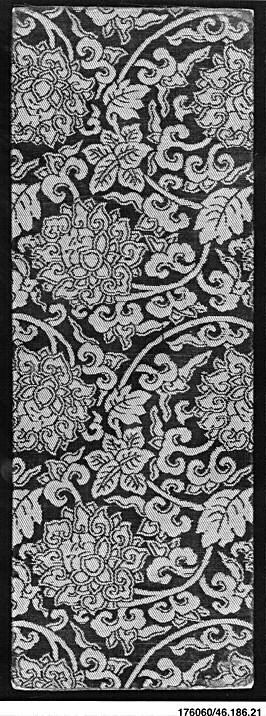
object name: sutra cover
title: Sutra Cover with Floral Scroll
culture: chinese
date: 1501-1600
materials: silk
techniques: patterning, weave